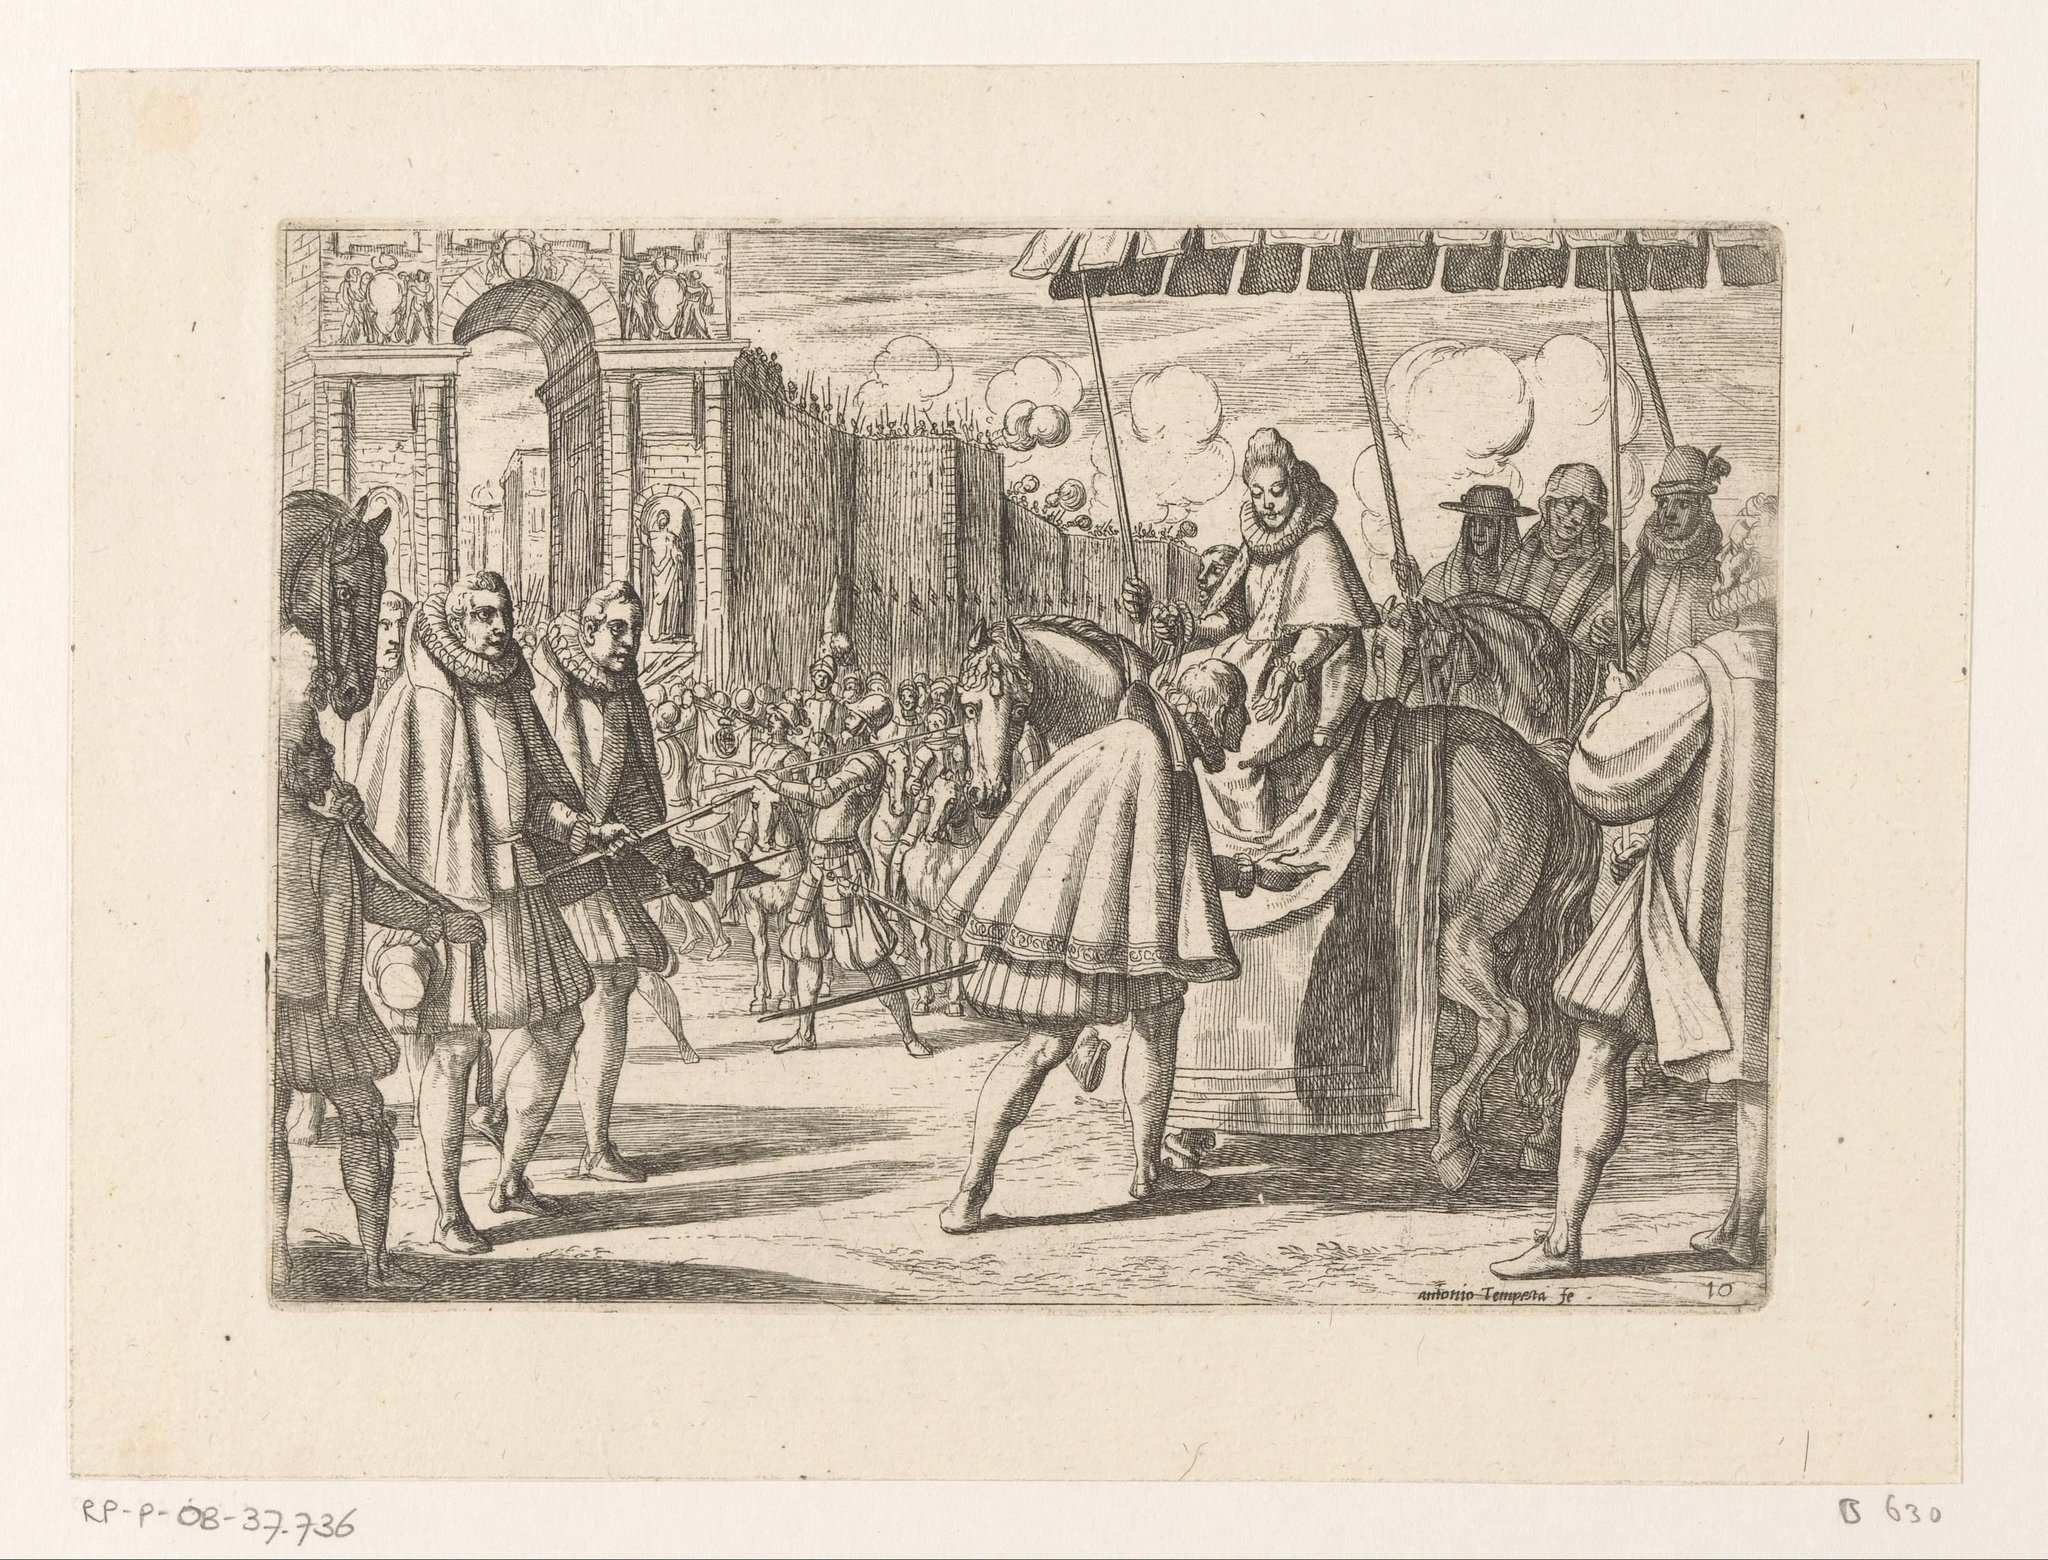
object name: print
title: Het leven van Margaretha van Oostenrijk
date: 1565-1630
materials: paper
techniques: etching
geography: italy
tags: margaretha van oostenrijk (koningin van spanje), triumphal entry and public reception, pageant, 'entrée solennelle', 'joyeuse entrée'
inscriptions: collector's mark: Lugt 240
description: Deze prent maakt deel uit van een reeks van zes prenten. Naar een schilderij dat wordt toegeschreven aan Tiberio di Tito en wordt bewaard in de Depositi Gallerie in Florence (inv. nr. 1890, no. 7792).